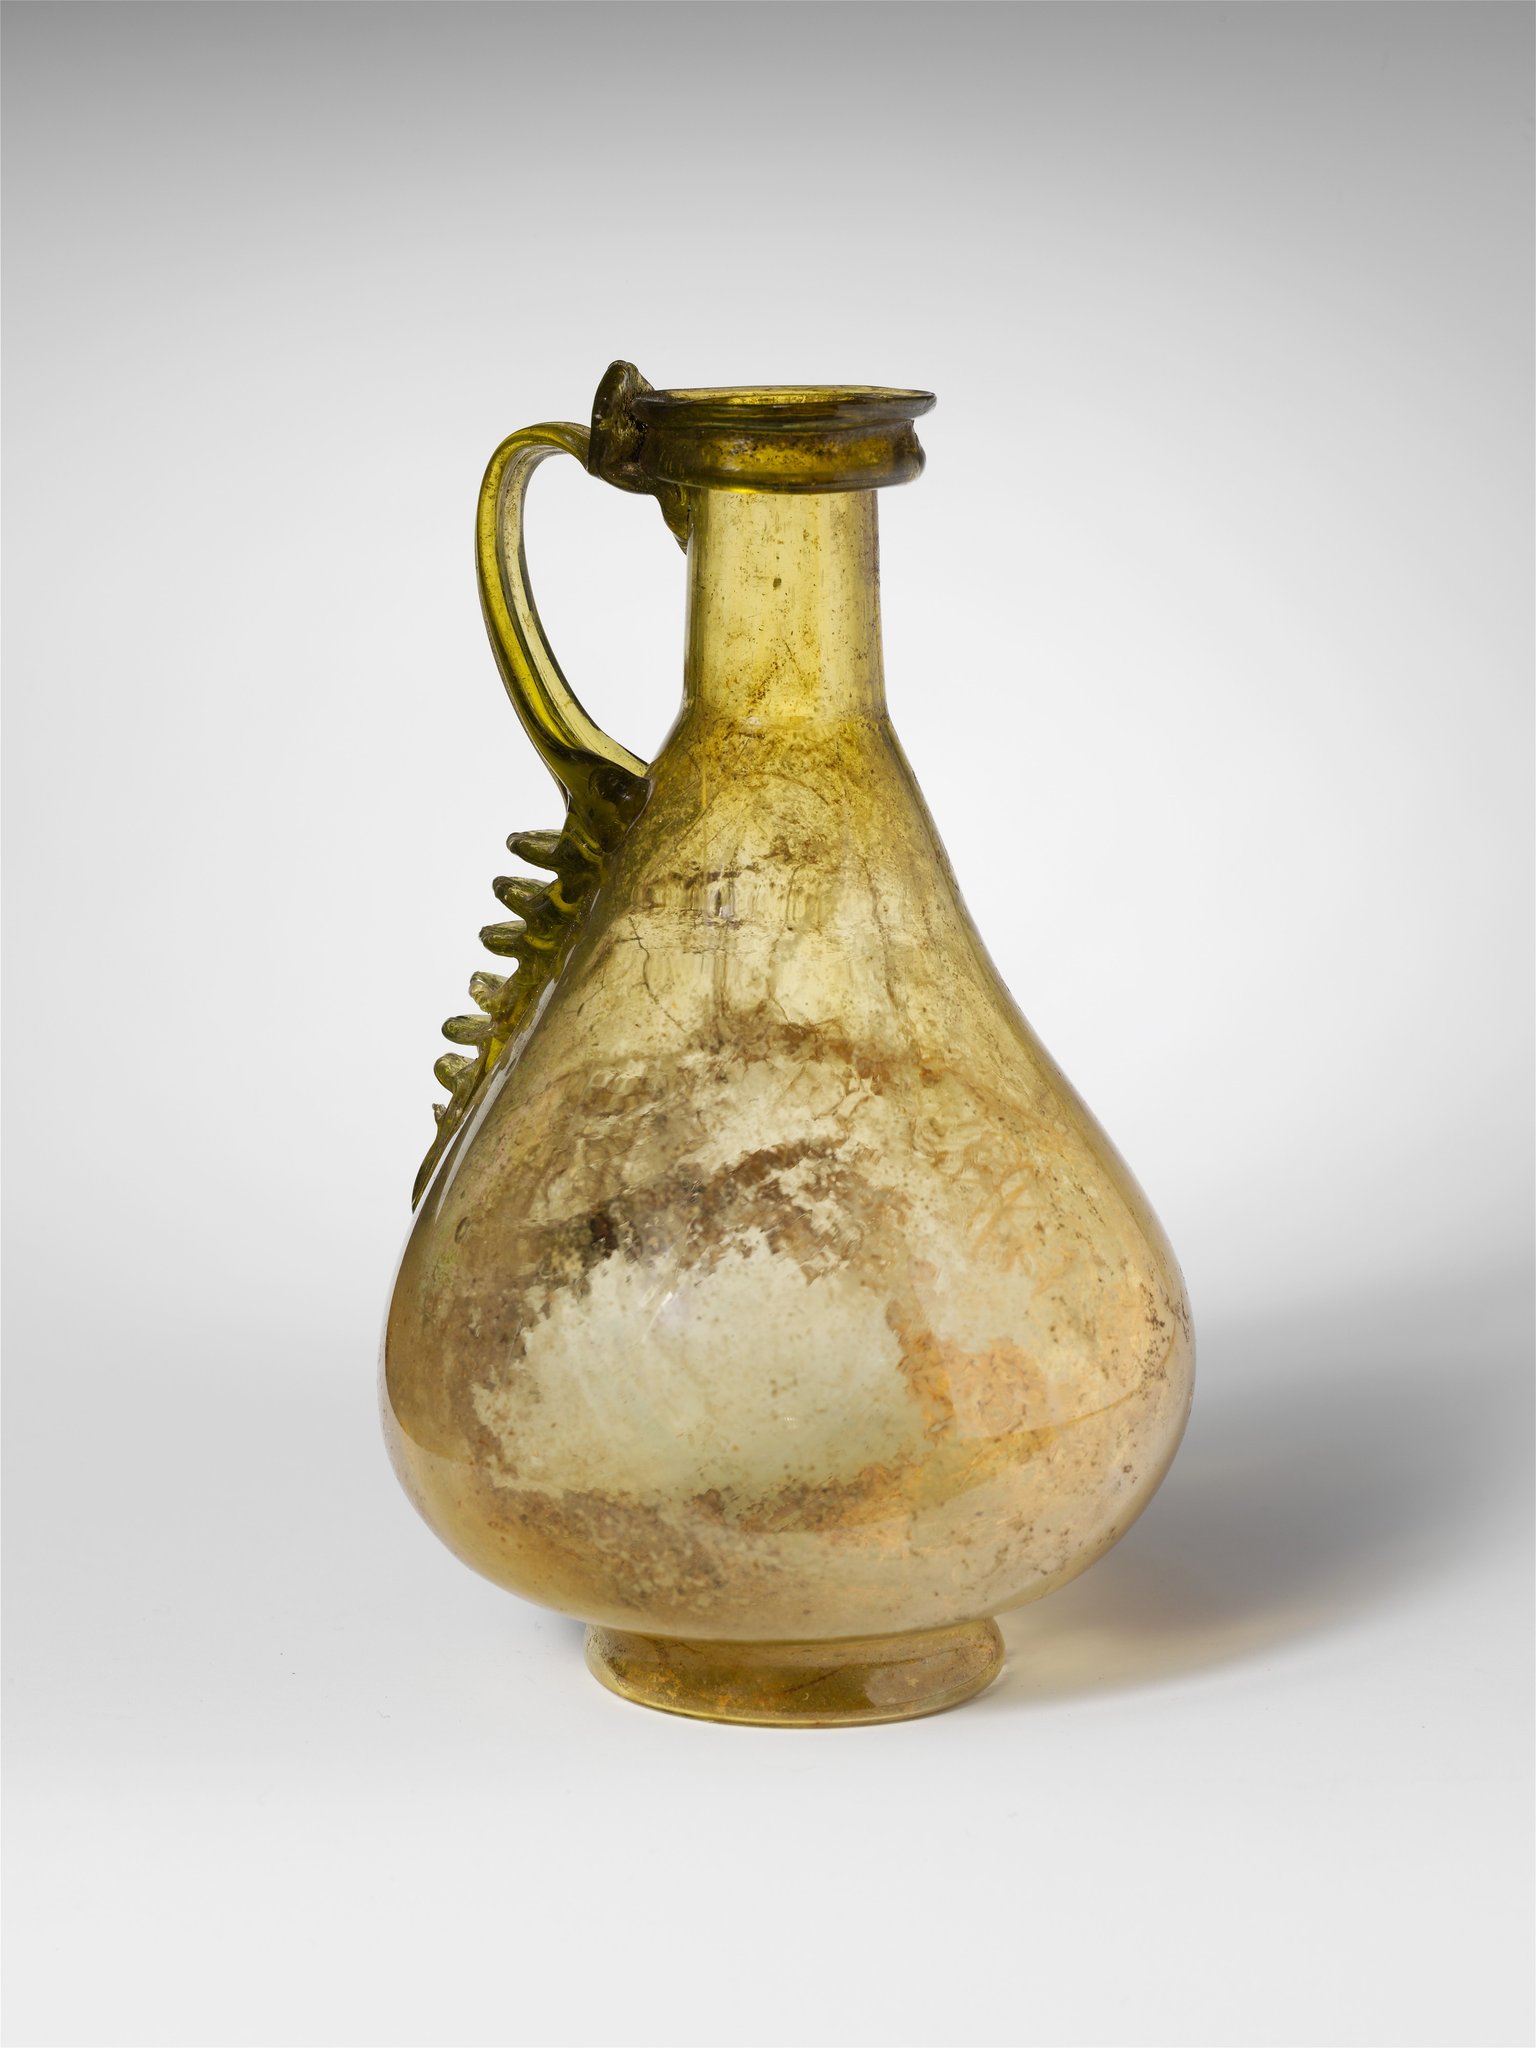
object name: bottle, two handled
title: Glass one-handled bottle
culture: roman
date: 67-133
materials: glass